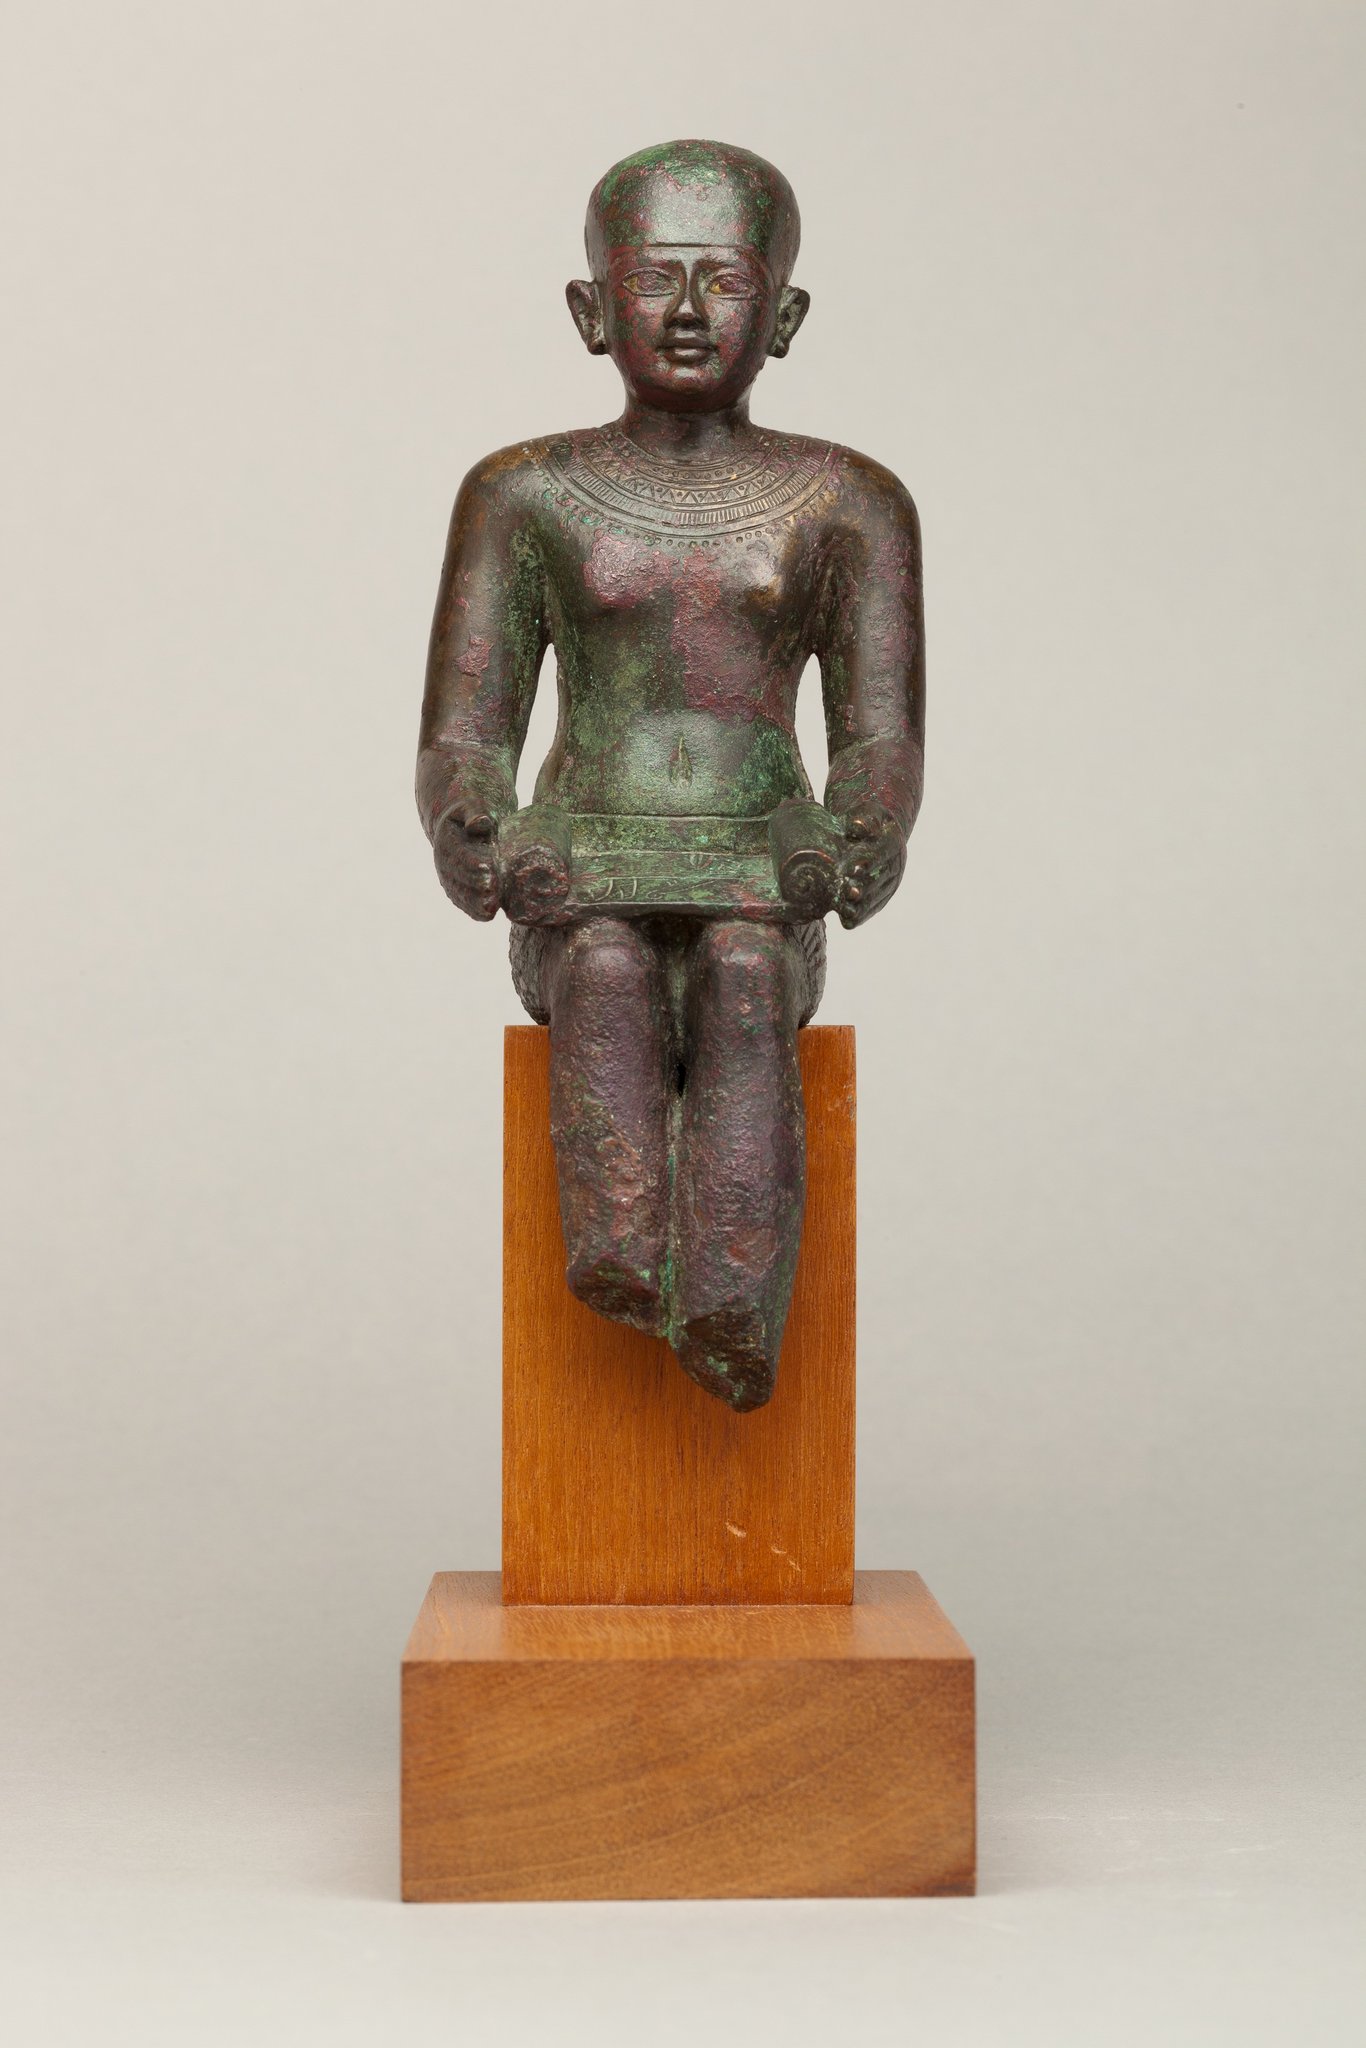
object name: statuette, imhotep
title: Statuette of Imhotep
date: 664-630 BCE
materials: metal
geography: egypt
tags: men